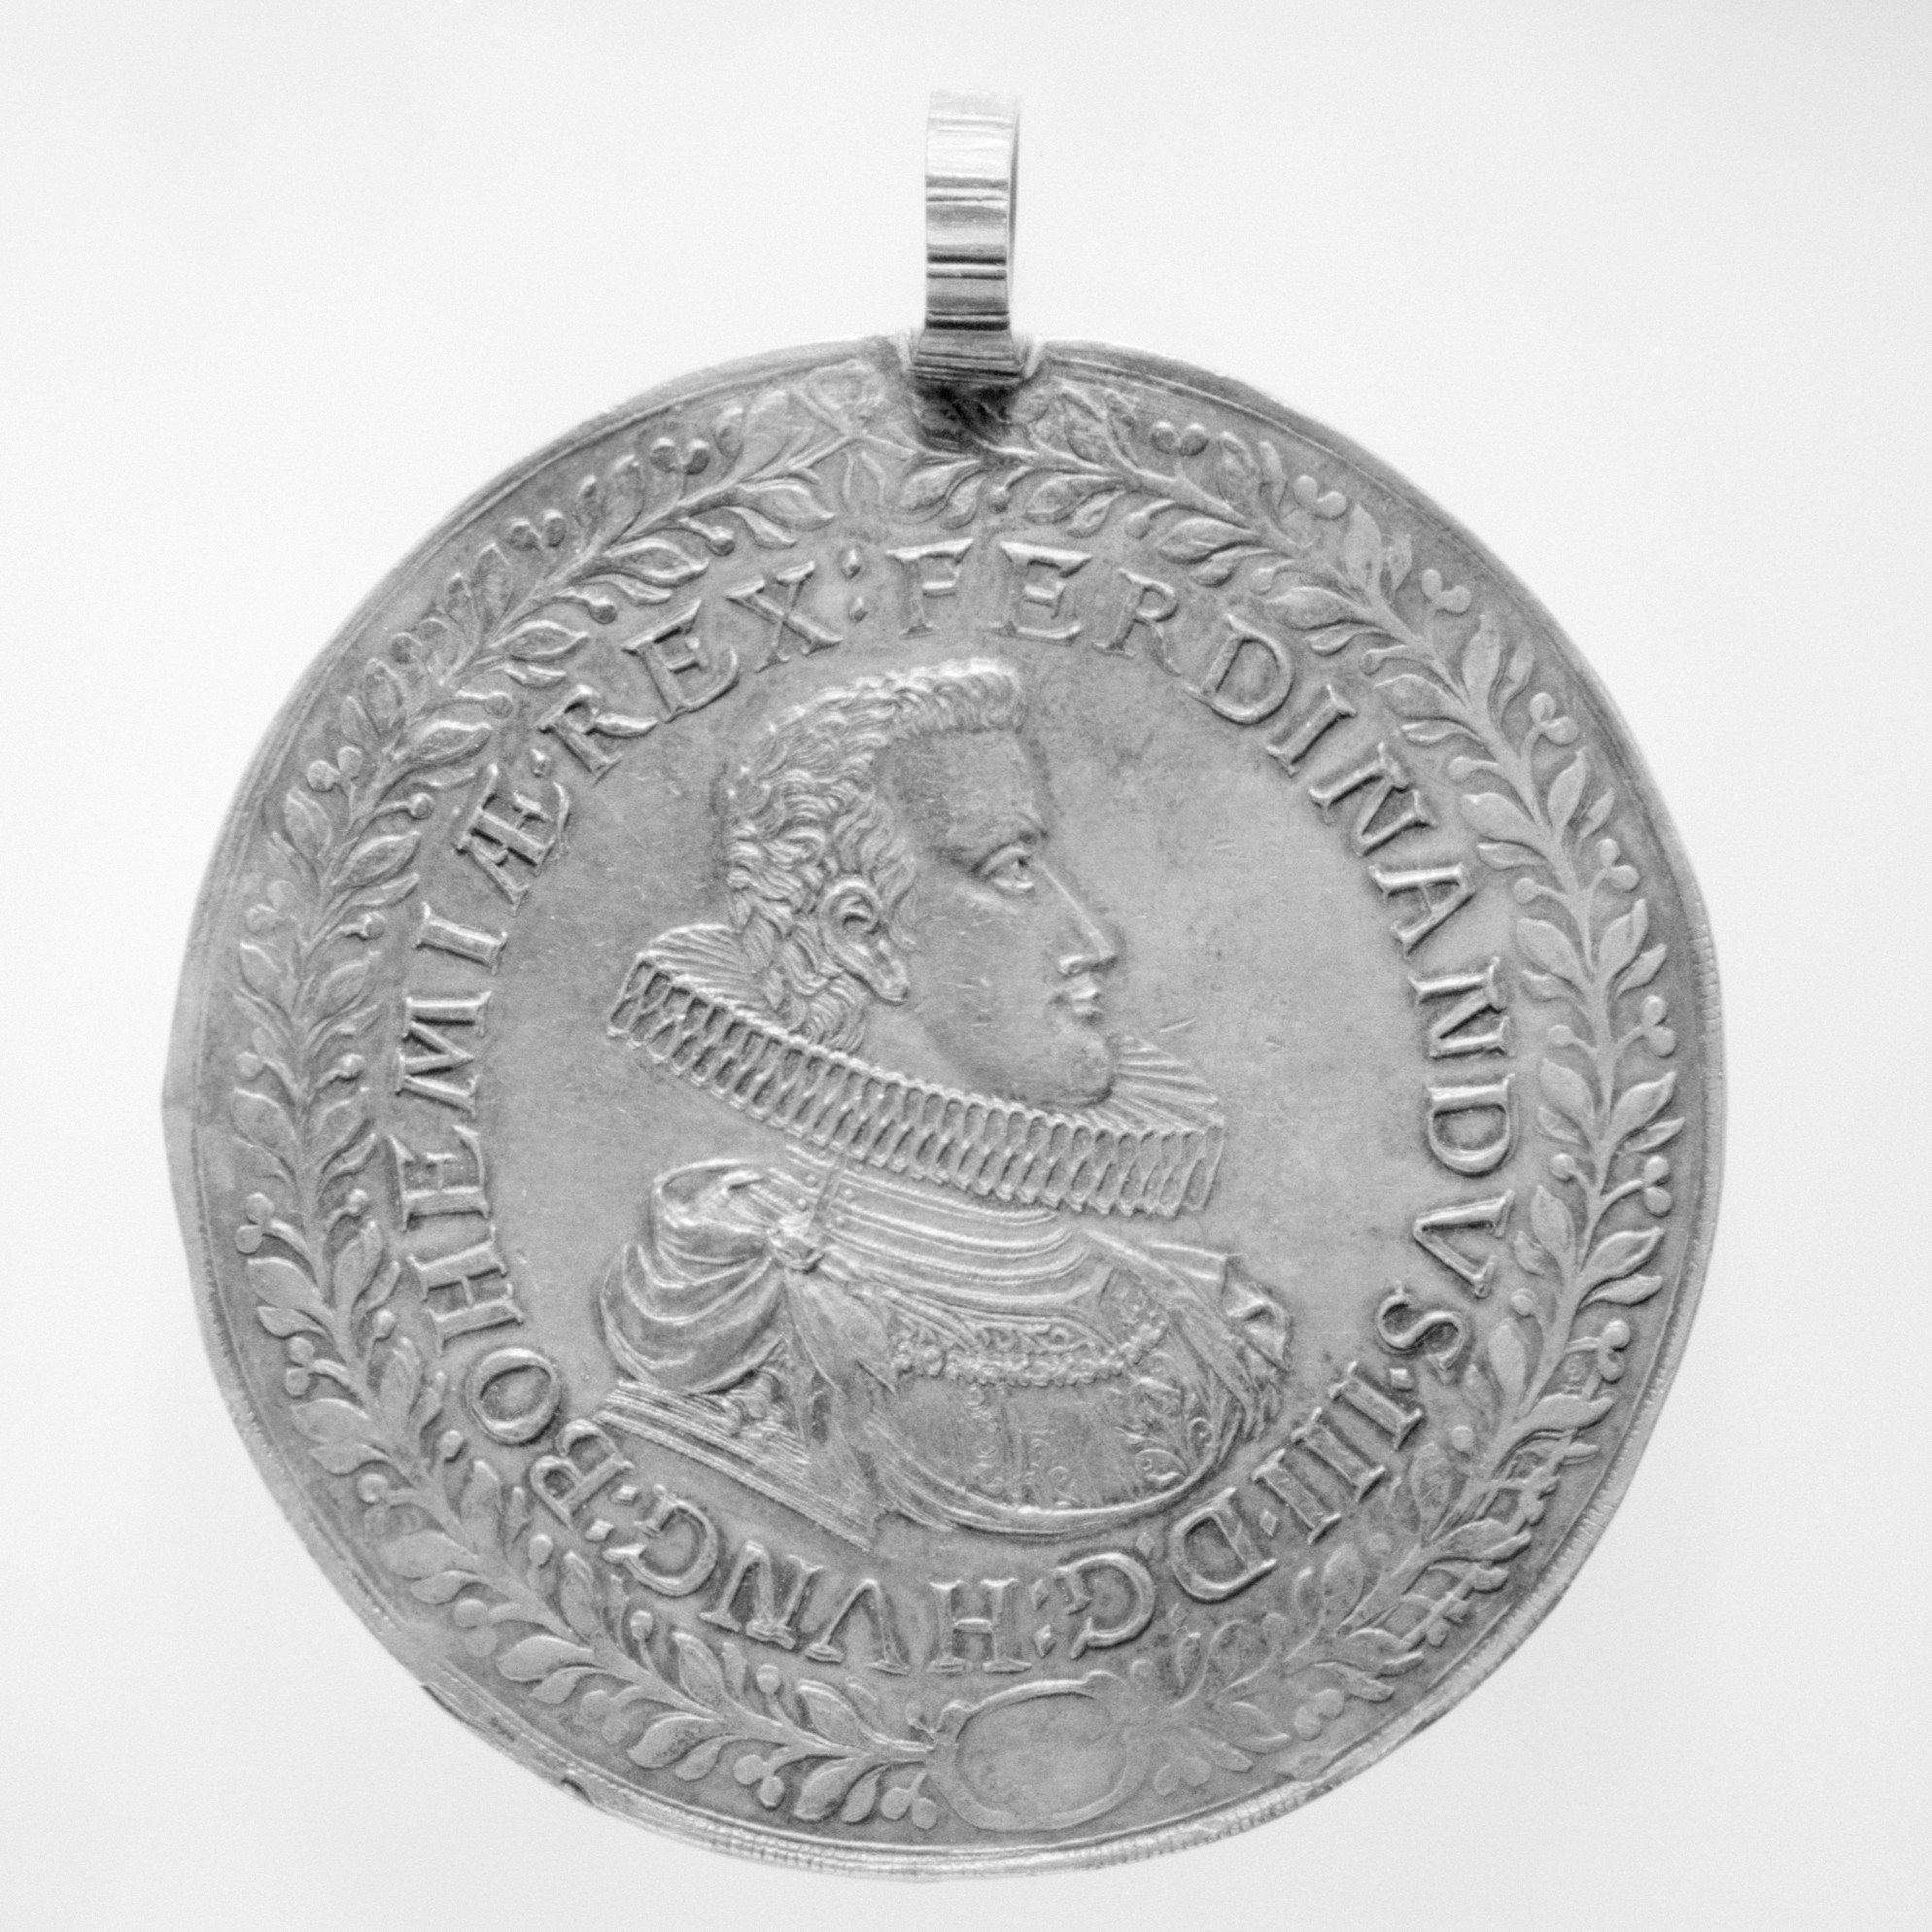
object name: medal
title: Ferdinand III of Bohemia and Hungary (1608–57)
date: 1629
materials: silver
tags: men,profiles,coat of arms